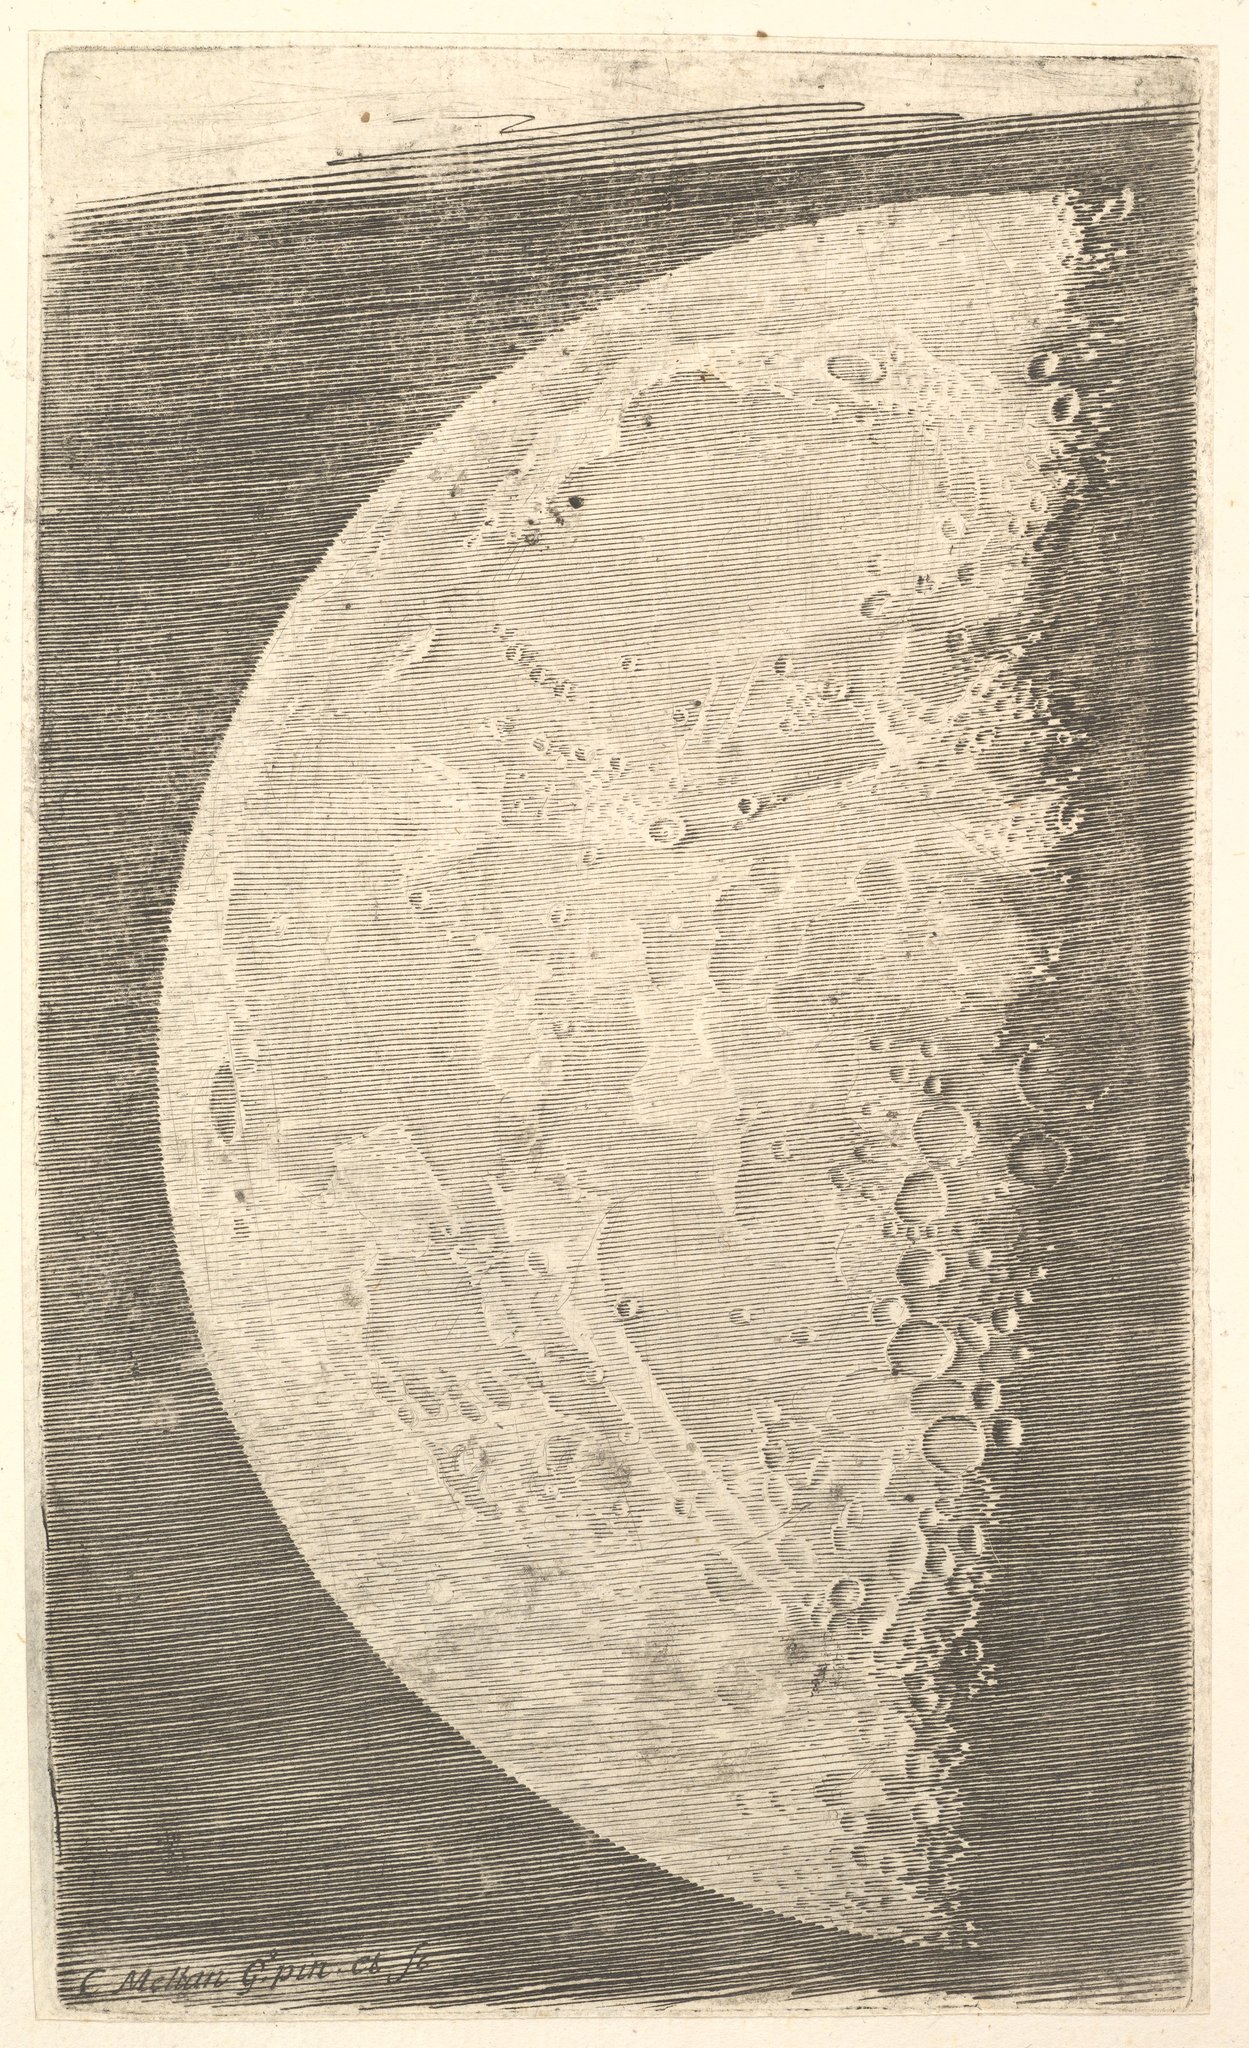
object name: print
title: The Moon in its Final Quarter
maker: claude mellan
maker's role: artist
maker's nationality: french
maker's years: 1598-1688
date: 1635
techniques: engraving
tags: moon